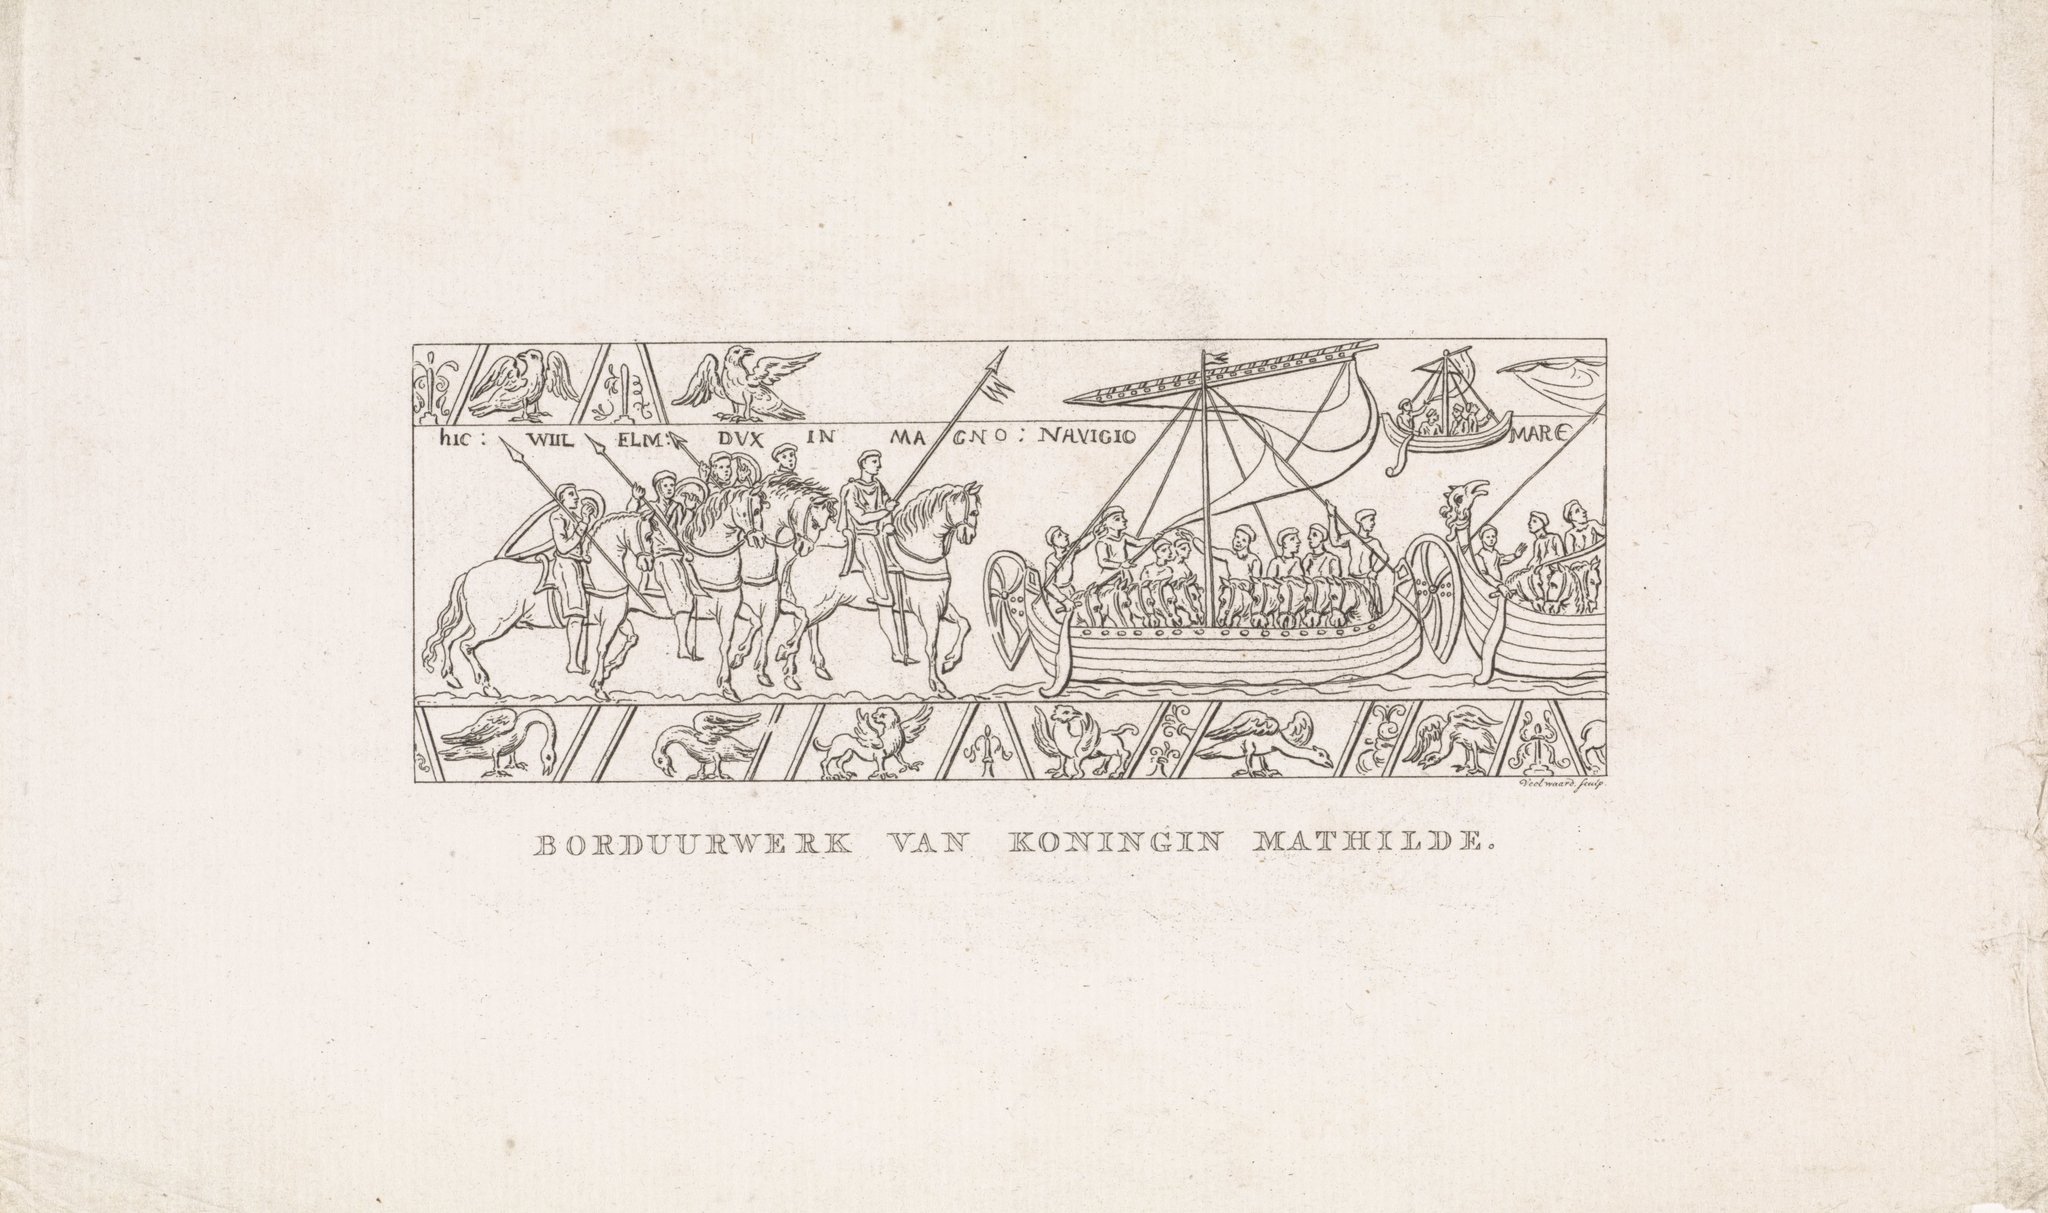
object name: print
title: Willem I de Veroveraar op het borduurwerk van koningin Mathilde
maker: daniël veelwaard (i)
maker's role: print maker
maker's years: 1766-1851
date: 1776-1851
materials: paper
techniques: etching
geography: amsterdam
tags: embroidery (ornamentation)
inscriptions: collector's mark: Lugt 2228